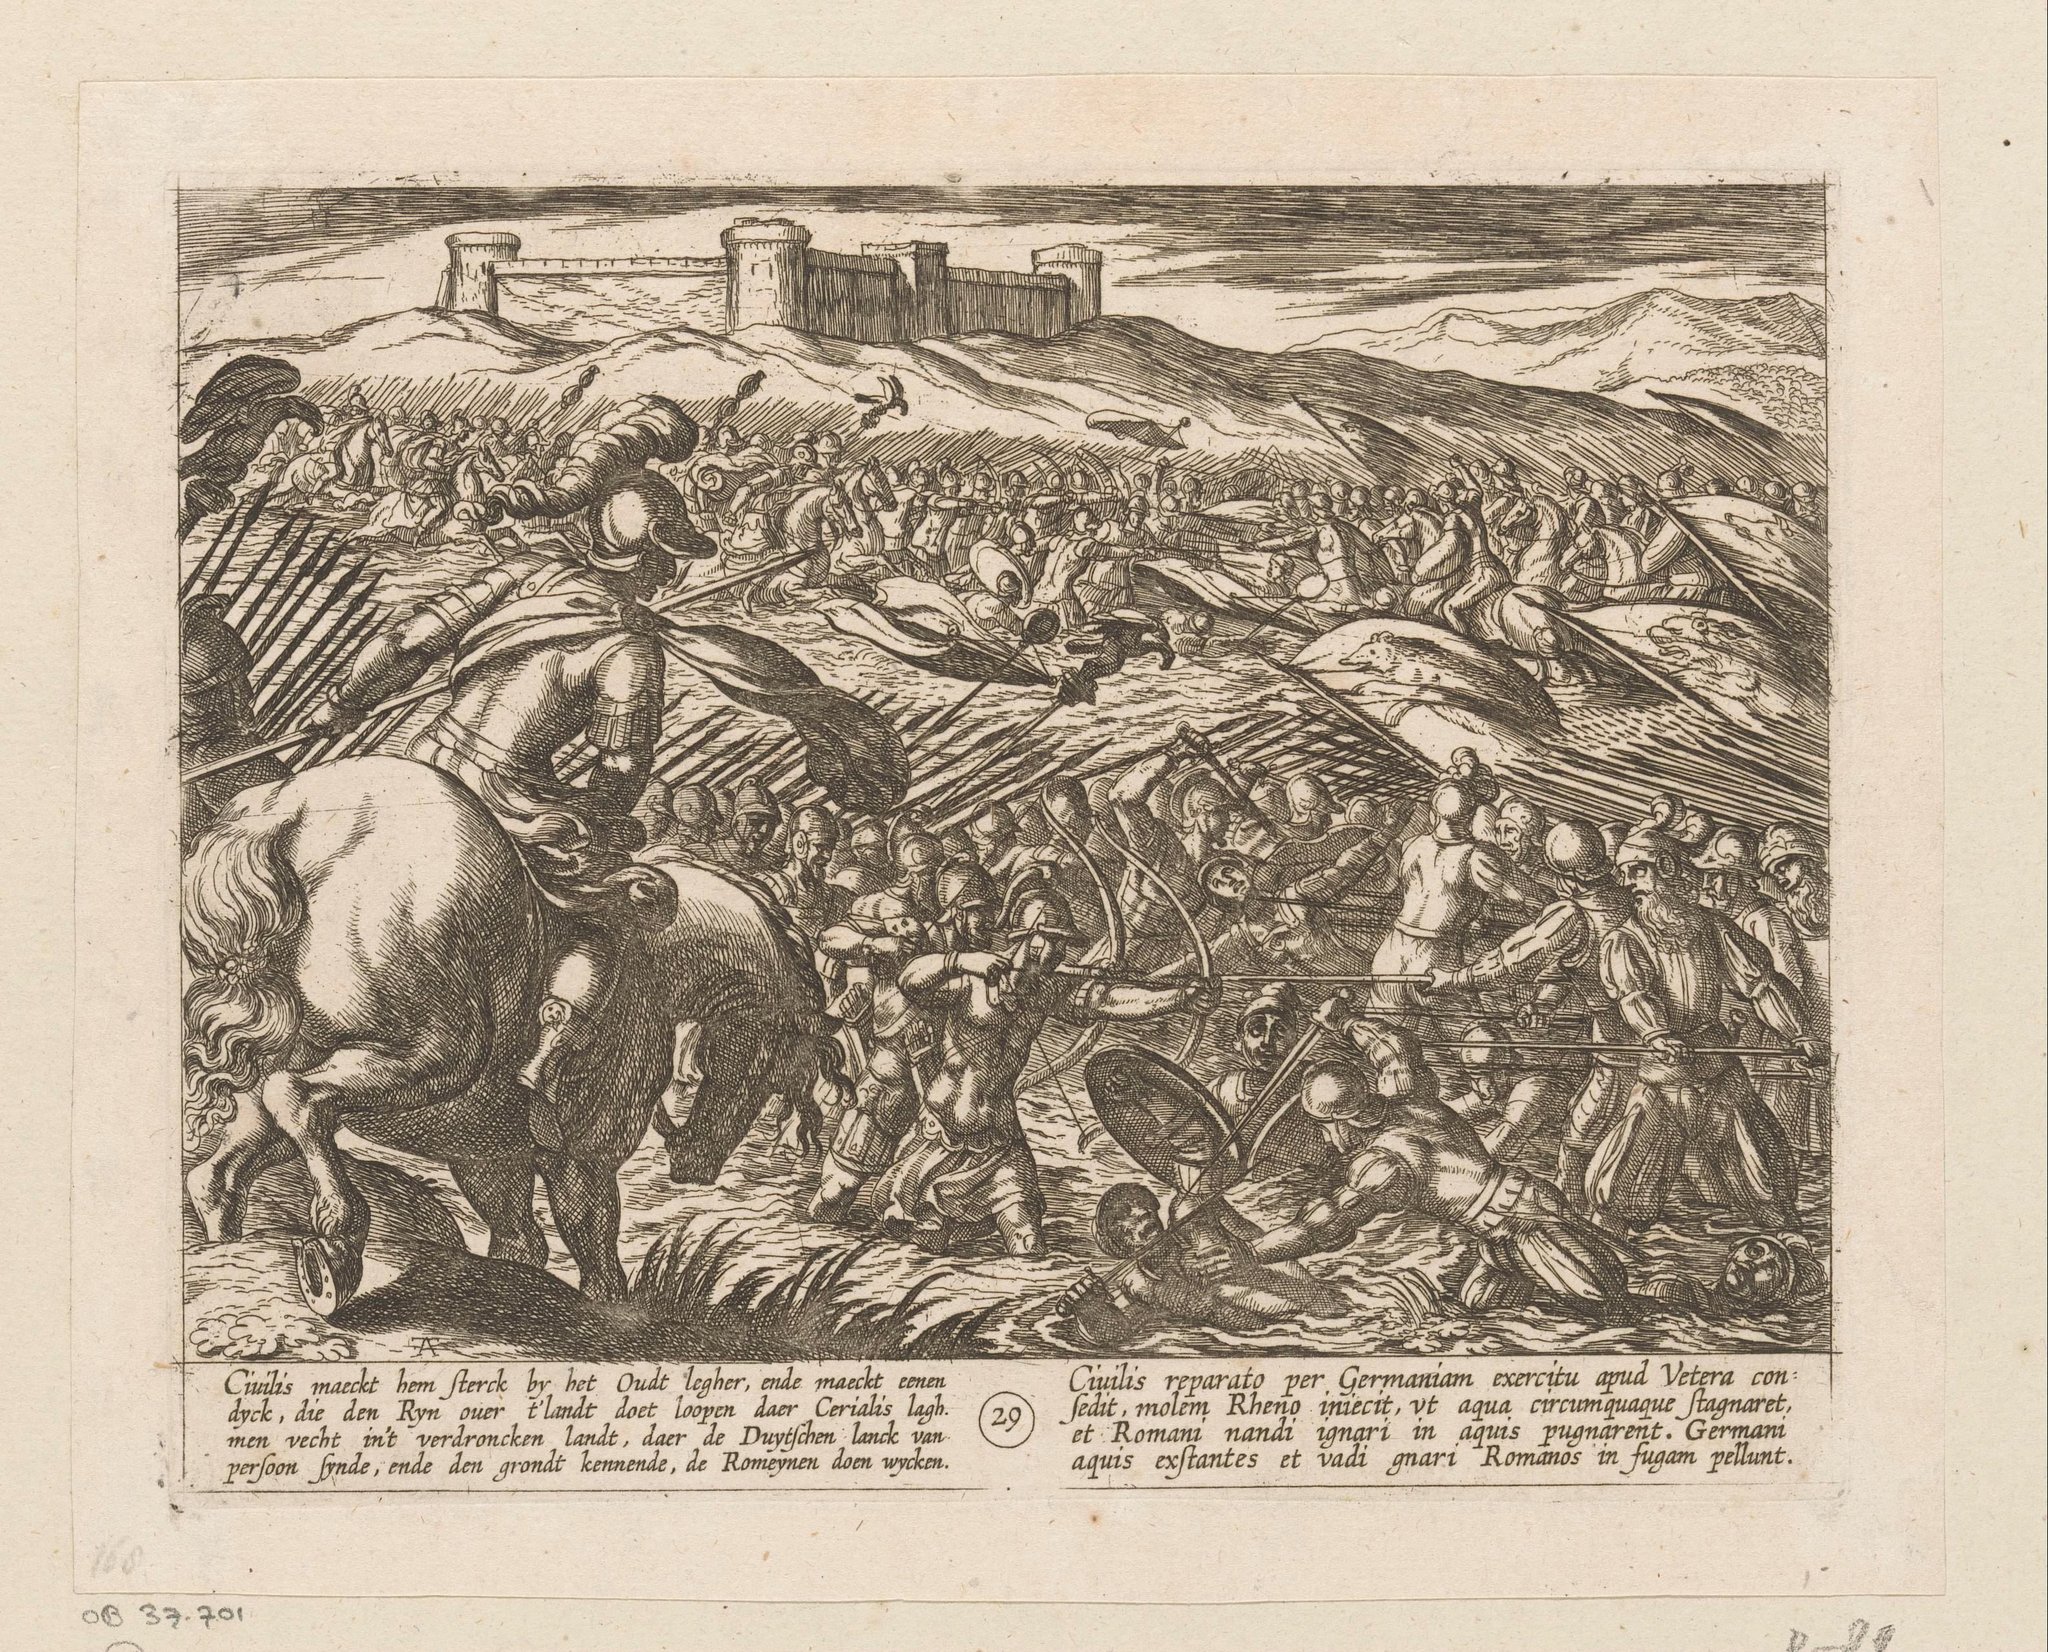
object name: print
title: Civilis laat het land onder water lopen, 69-70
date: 1612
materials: paper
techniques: etching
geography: italy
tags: dike-break, battle, fighting in general, extinct, 'historical' peoples (with name), netherlands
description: De Bataven strijden tegen de Romeinen op het land dat Civilis onder water heeft laten lopen. Prent nummer 29 in de serie prenten over de Bataafse Opstand: Batavorum cum Romanis bellum / à Corn. Tacito lib. IV & V. : Hist. olim descriptum, figuris nunc aeneis expressum, auctore Othone Vaenio Lugdunobatava = De Batavische oft oude Hollandtsche oorloghe teghen de Romeynen. Otto Vaenius, Antwerpen 1612. Onderaan twee verzen van vier regels in het Nederlands en in het Latijn. Zonder tekst op achterzijde.